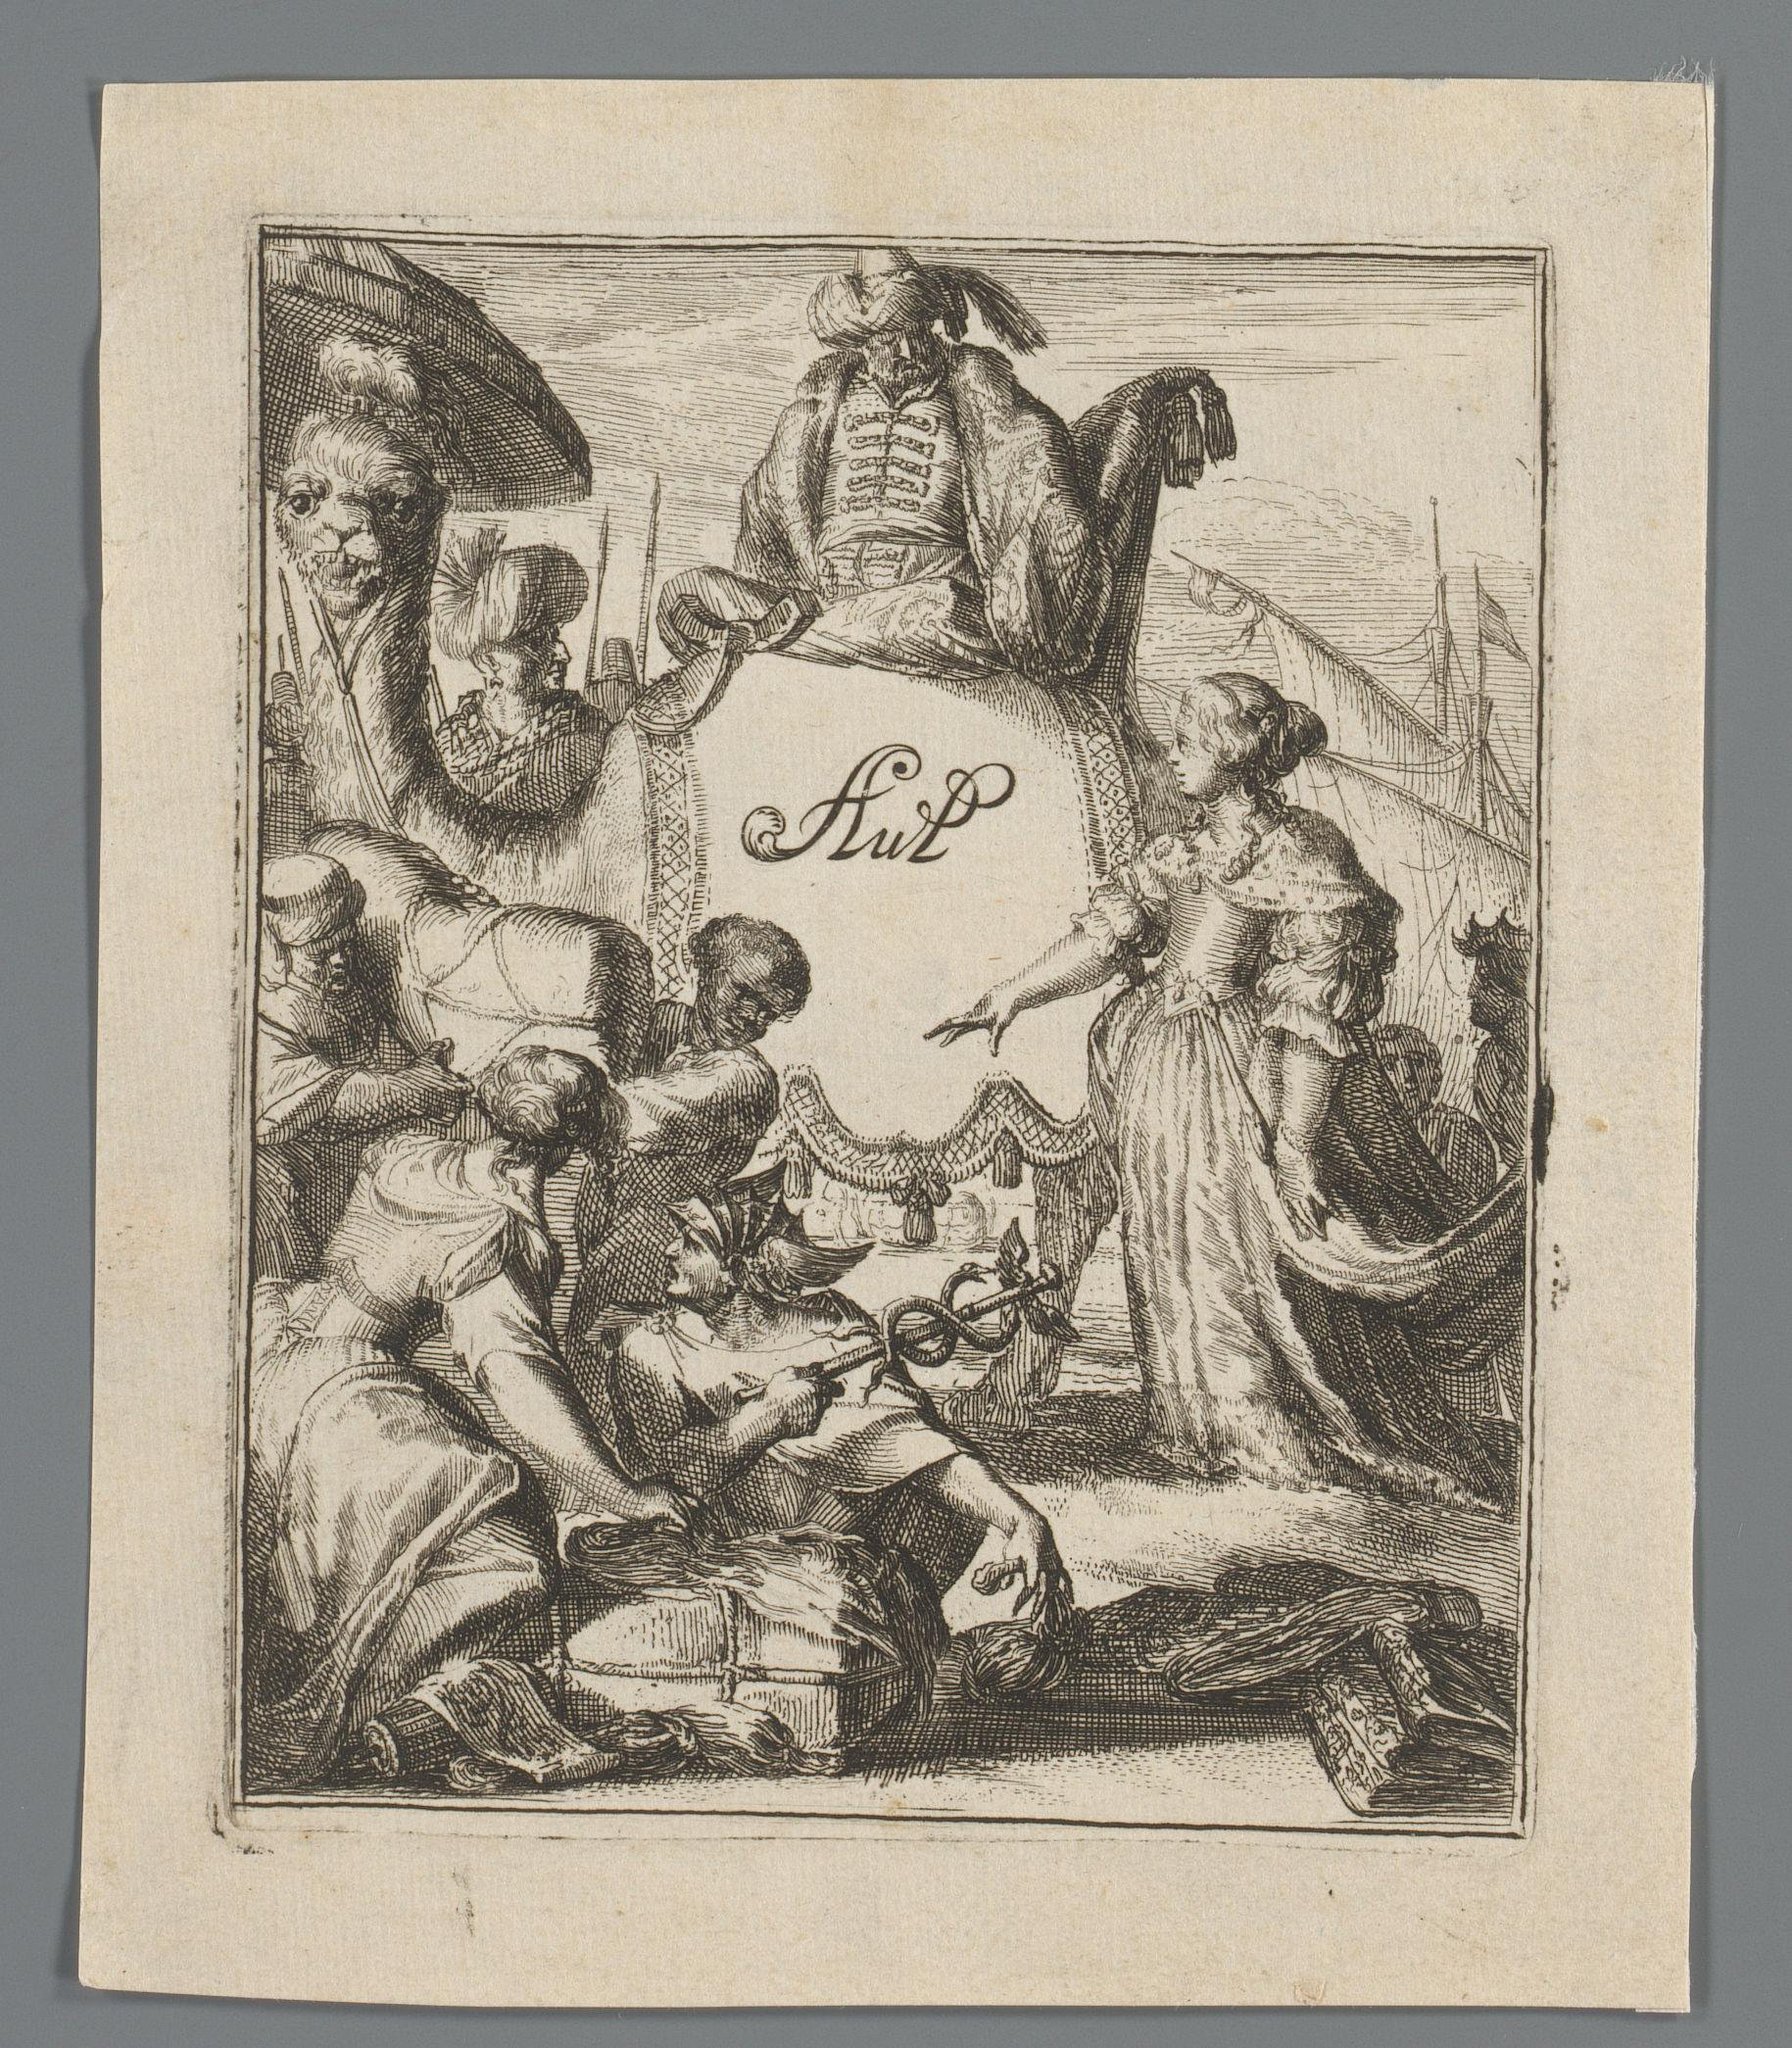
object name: print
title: Adreskaart met koopman op dromedaris bij een markt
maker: Anonymous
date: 1600-1699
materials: paper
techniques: etching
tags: hoofed animals: dromedary, (story of) mercury (hermes), merchant, salesman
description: Bij de koopman staat een vrouw te onderhandelen. Op de voorgrond zit Mercurius geknield op de grond terwijl een pakket wordt geïnspecteerd. Op het zadeldek van de kameel het monogram 'AvL'.